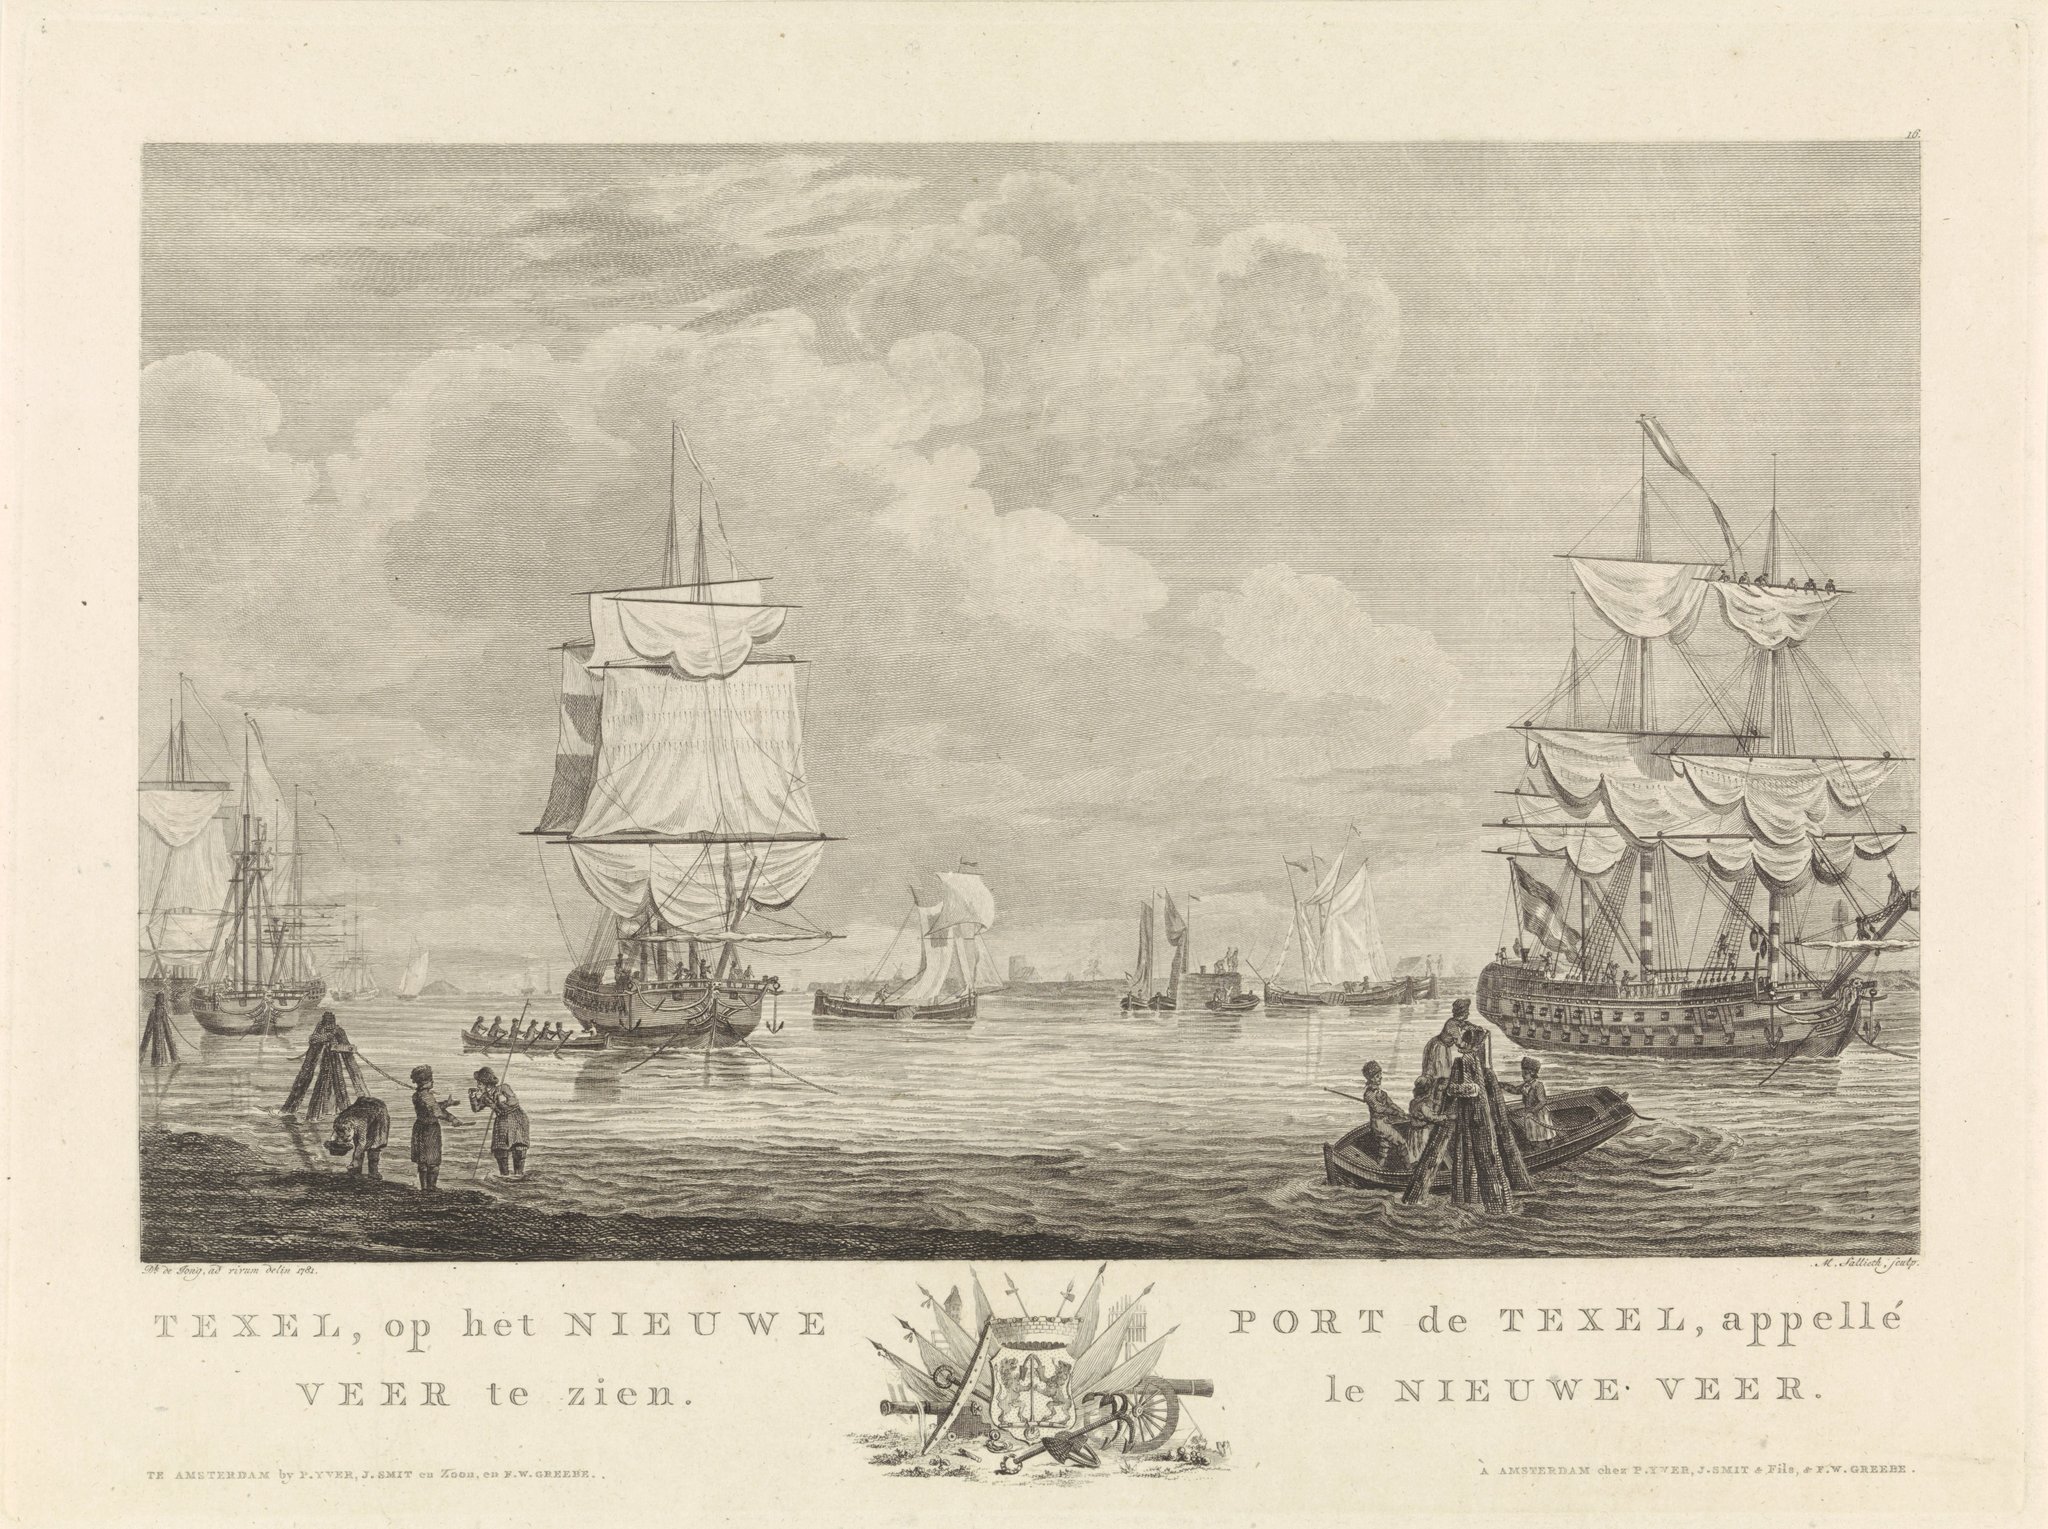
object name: print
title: Gezicht op Texel bij het Nieuwe Veer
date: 1781-1787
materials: paper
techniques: etching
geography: amsterdam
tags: coat of arms (as symbol of the state, etc.), coat of arms (as symbol of the state, etc.) (+ city; municipal), sailing-ship, sailing-boat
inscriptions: collector's mark: Lugt 2228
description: Voor staat avant la lettre zie RP-P-AO-7-10A. Latere staat ook gebruikt in: Aa, Cornelis van der. Atlas van de zeehavens der Bataafsche Republiek. Met derzelver beschrijvingen in XXXI kunstplaaten / Atlas van de zeehavens der Bataafsche Republiek, die van Batavia en Onrust. Mitsgaders de afbeeldingen van de haringvisscherij en de walvischvangst […]. Amsterdam: Evert Maaskamp, 1805.